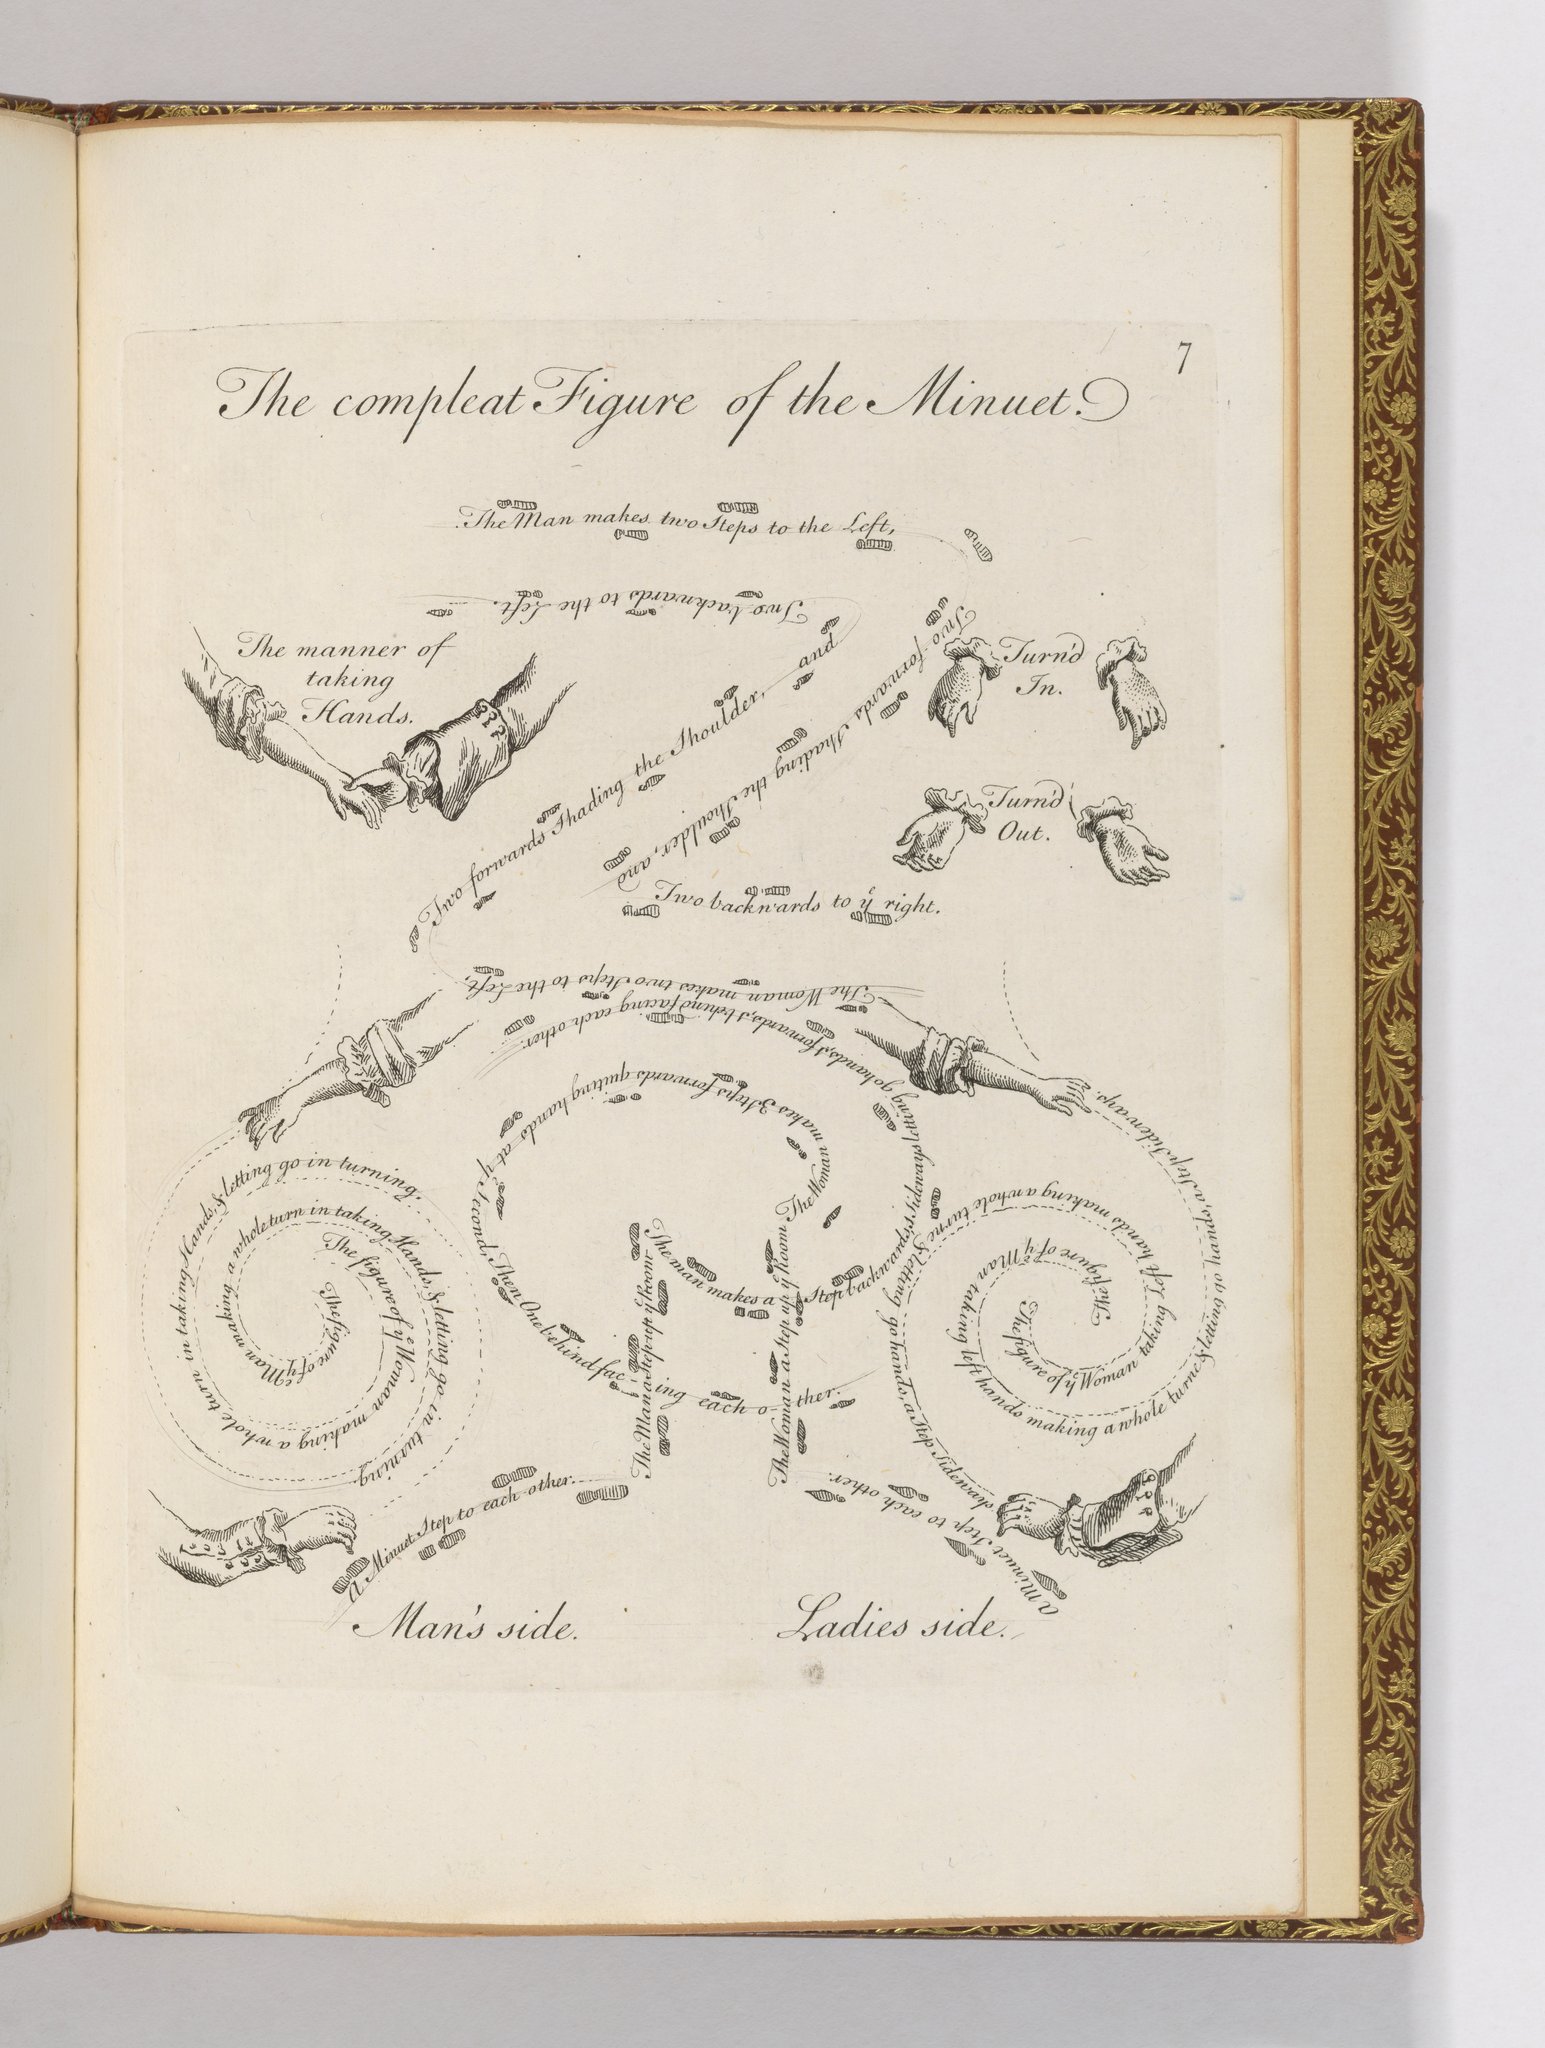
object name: book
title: An Easy Introduction to Dancing: or, the Movements in the Minuet full explained.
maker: george bickham, jr.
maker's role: artist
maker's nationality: british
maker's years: 1704-1771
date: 1738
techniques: etching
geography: england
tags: dancing